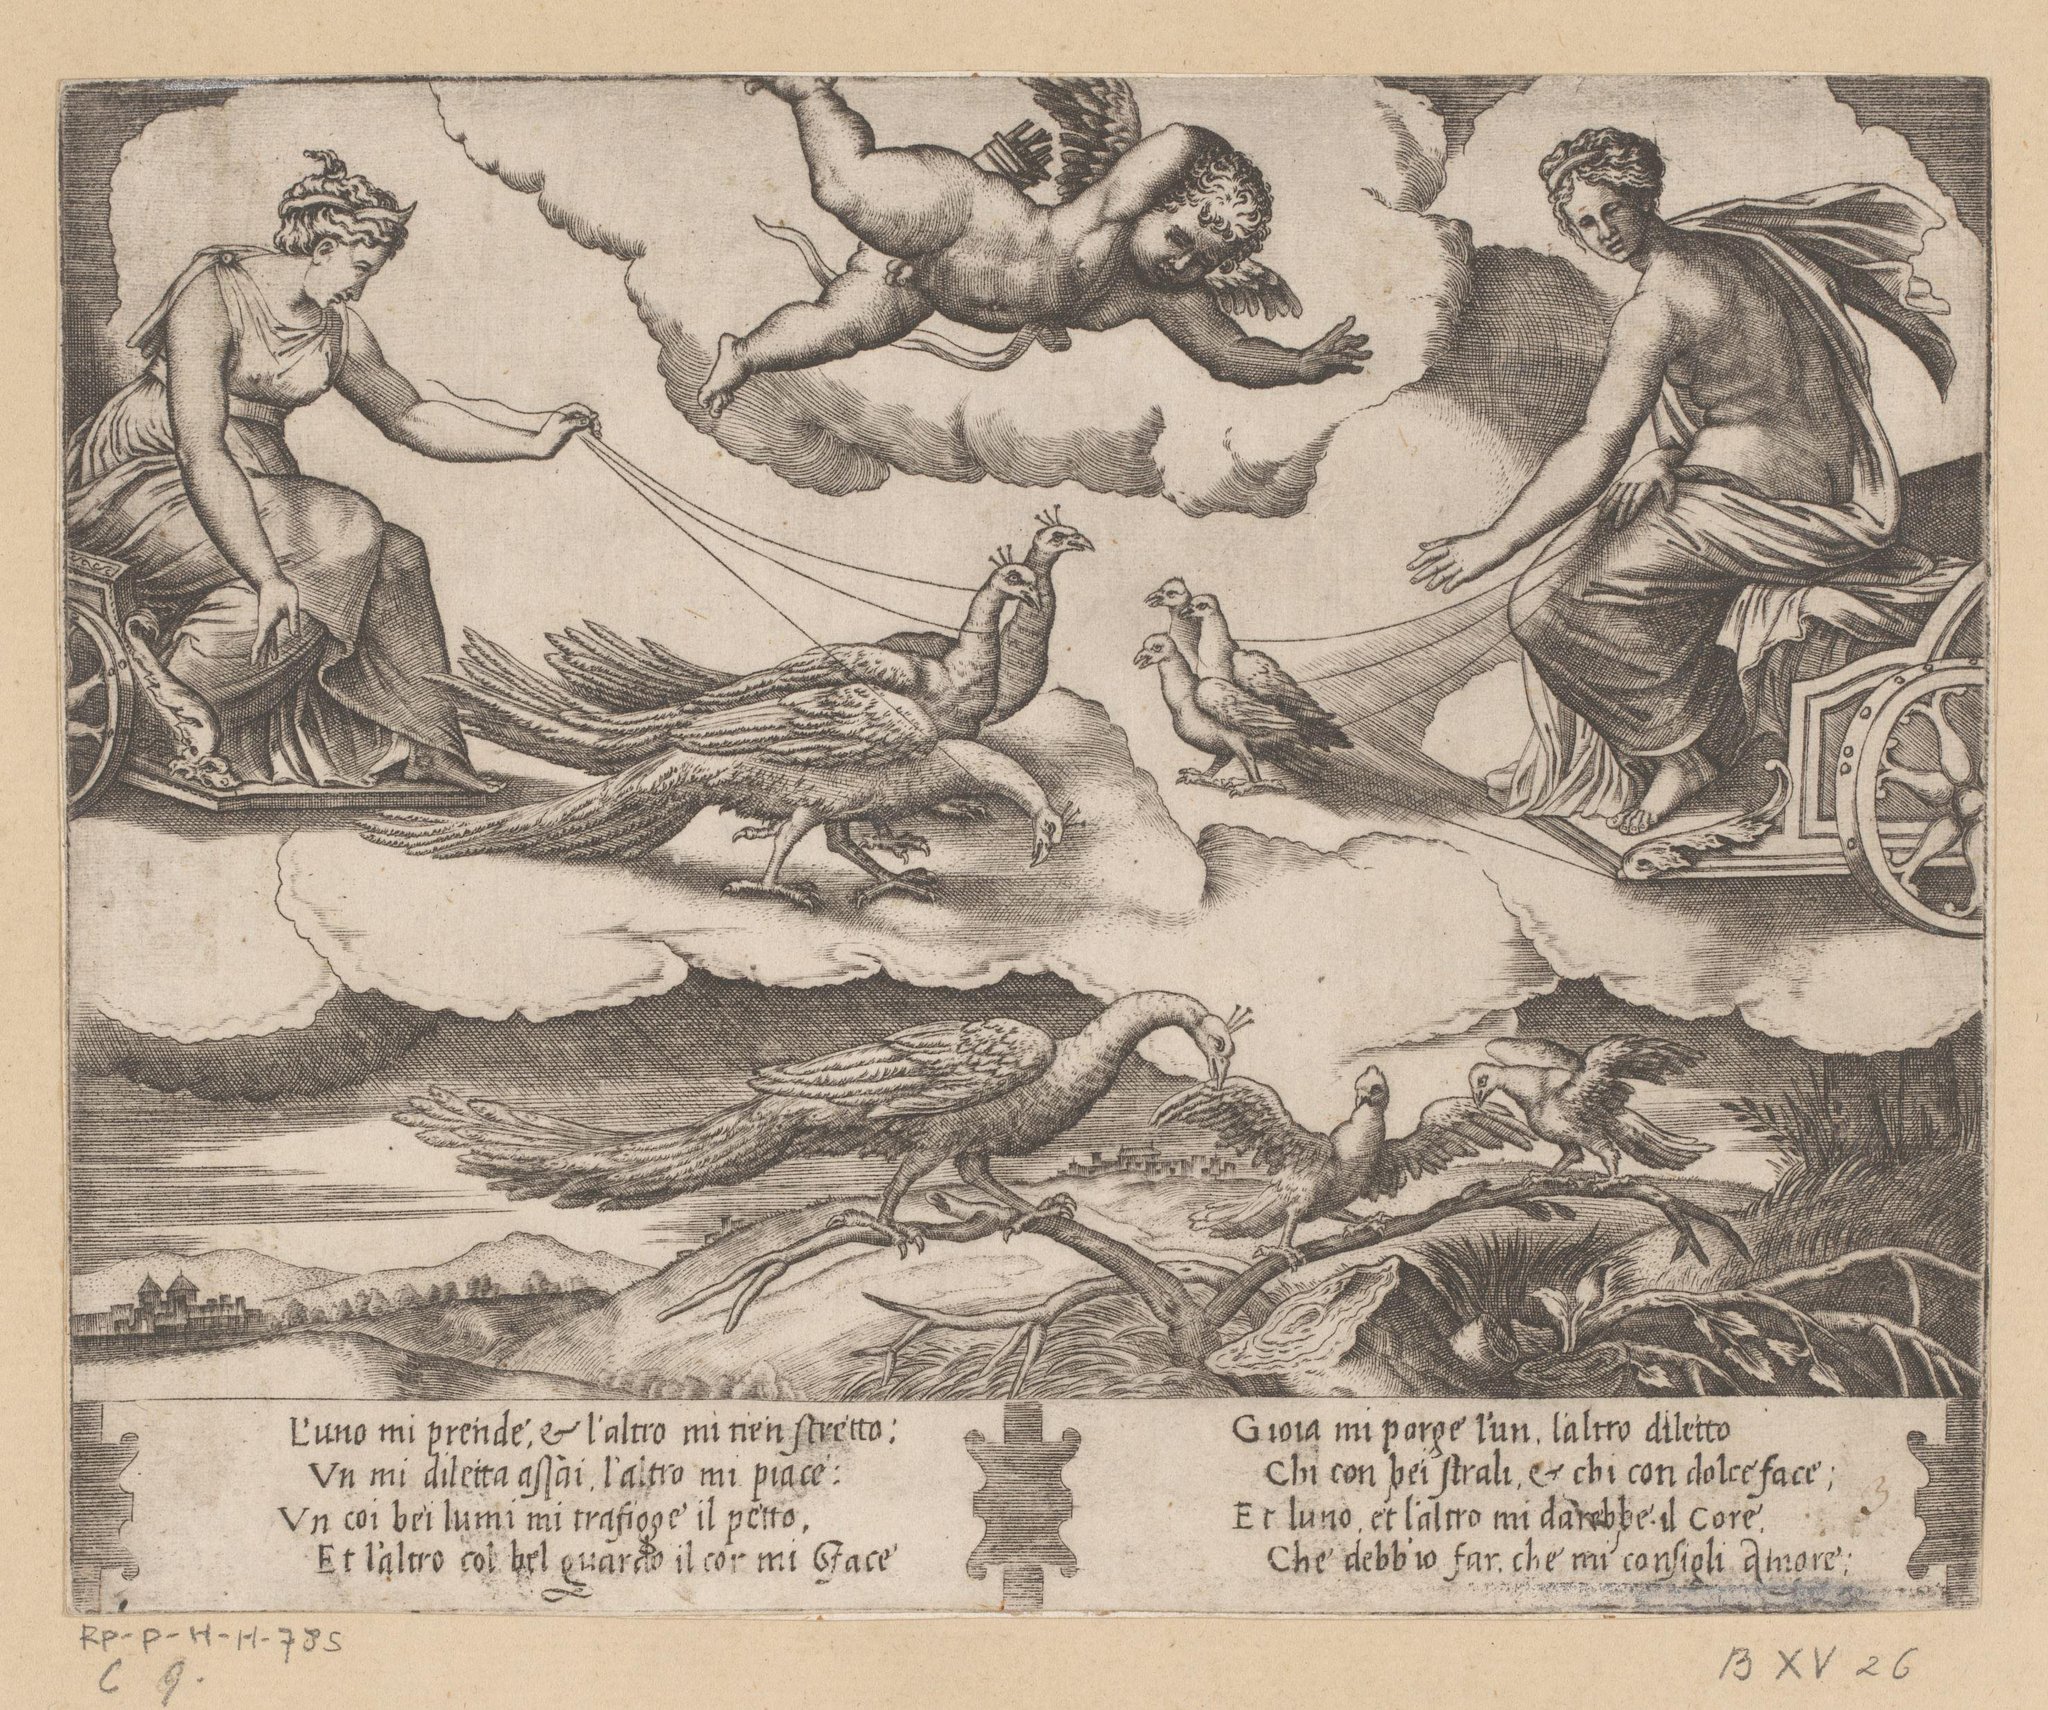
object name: print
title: Allegorie op het huwelijk en de liefde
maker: meester van de dobbelsteen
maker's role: print maker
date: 1530-1560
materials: paper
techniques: engraving, intaglio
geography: italy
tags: city-view, and landscape with man-made constructions, (story of) juno (hera), ornamental birds: peacock, (story of) cupid, amor (eros), (story of) venus (aphrodite)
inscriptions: collector's mark: Lugt 10, collector's mark: Lugt 11, number: ‘3’, collector's mark: ‘Hinloopen’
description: Een allegorie op het huwelijk en de liefde met Juno en Venus. Links zit Juno op een wagen getrokken door drie pauwen. Rechts wordt de wagen van Venus getrokken door drie duiven. Tussen hen in vliegt Amor met zijn pijlenkoker op de rug. Onder de goden een landschap met op de voorgrond een pauw, een duif en een andere vogel zittend op een tak. Italiaanse tekst in twee kolommen in ondermarge.